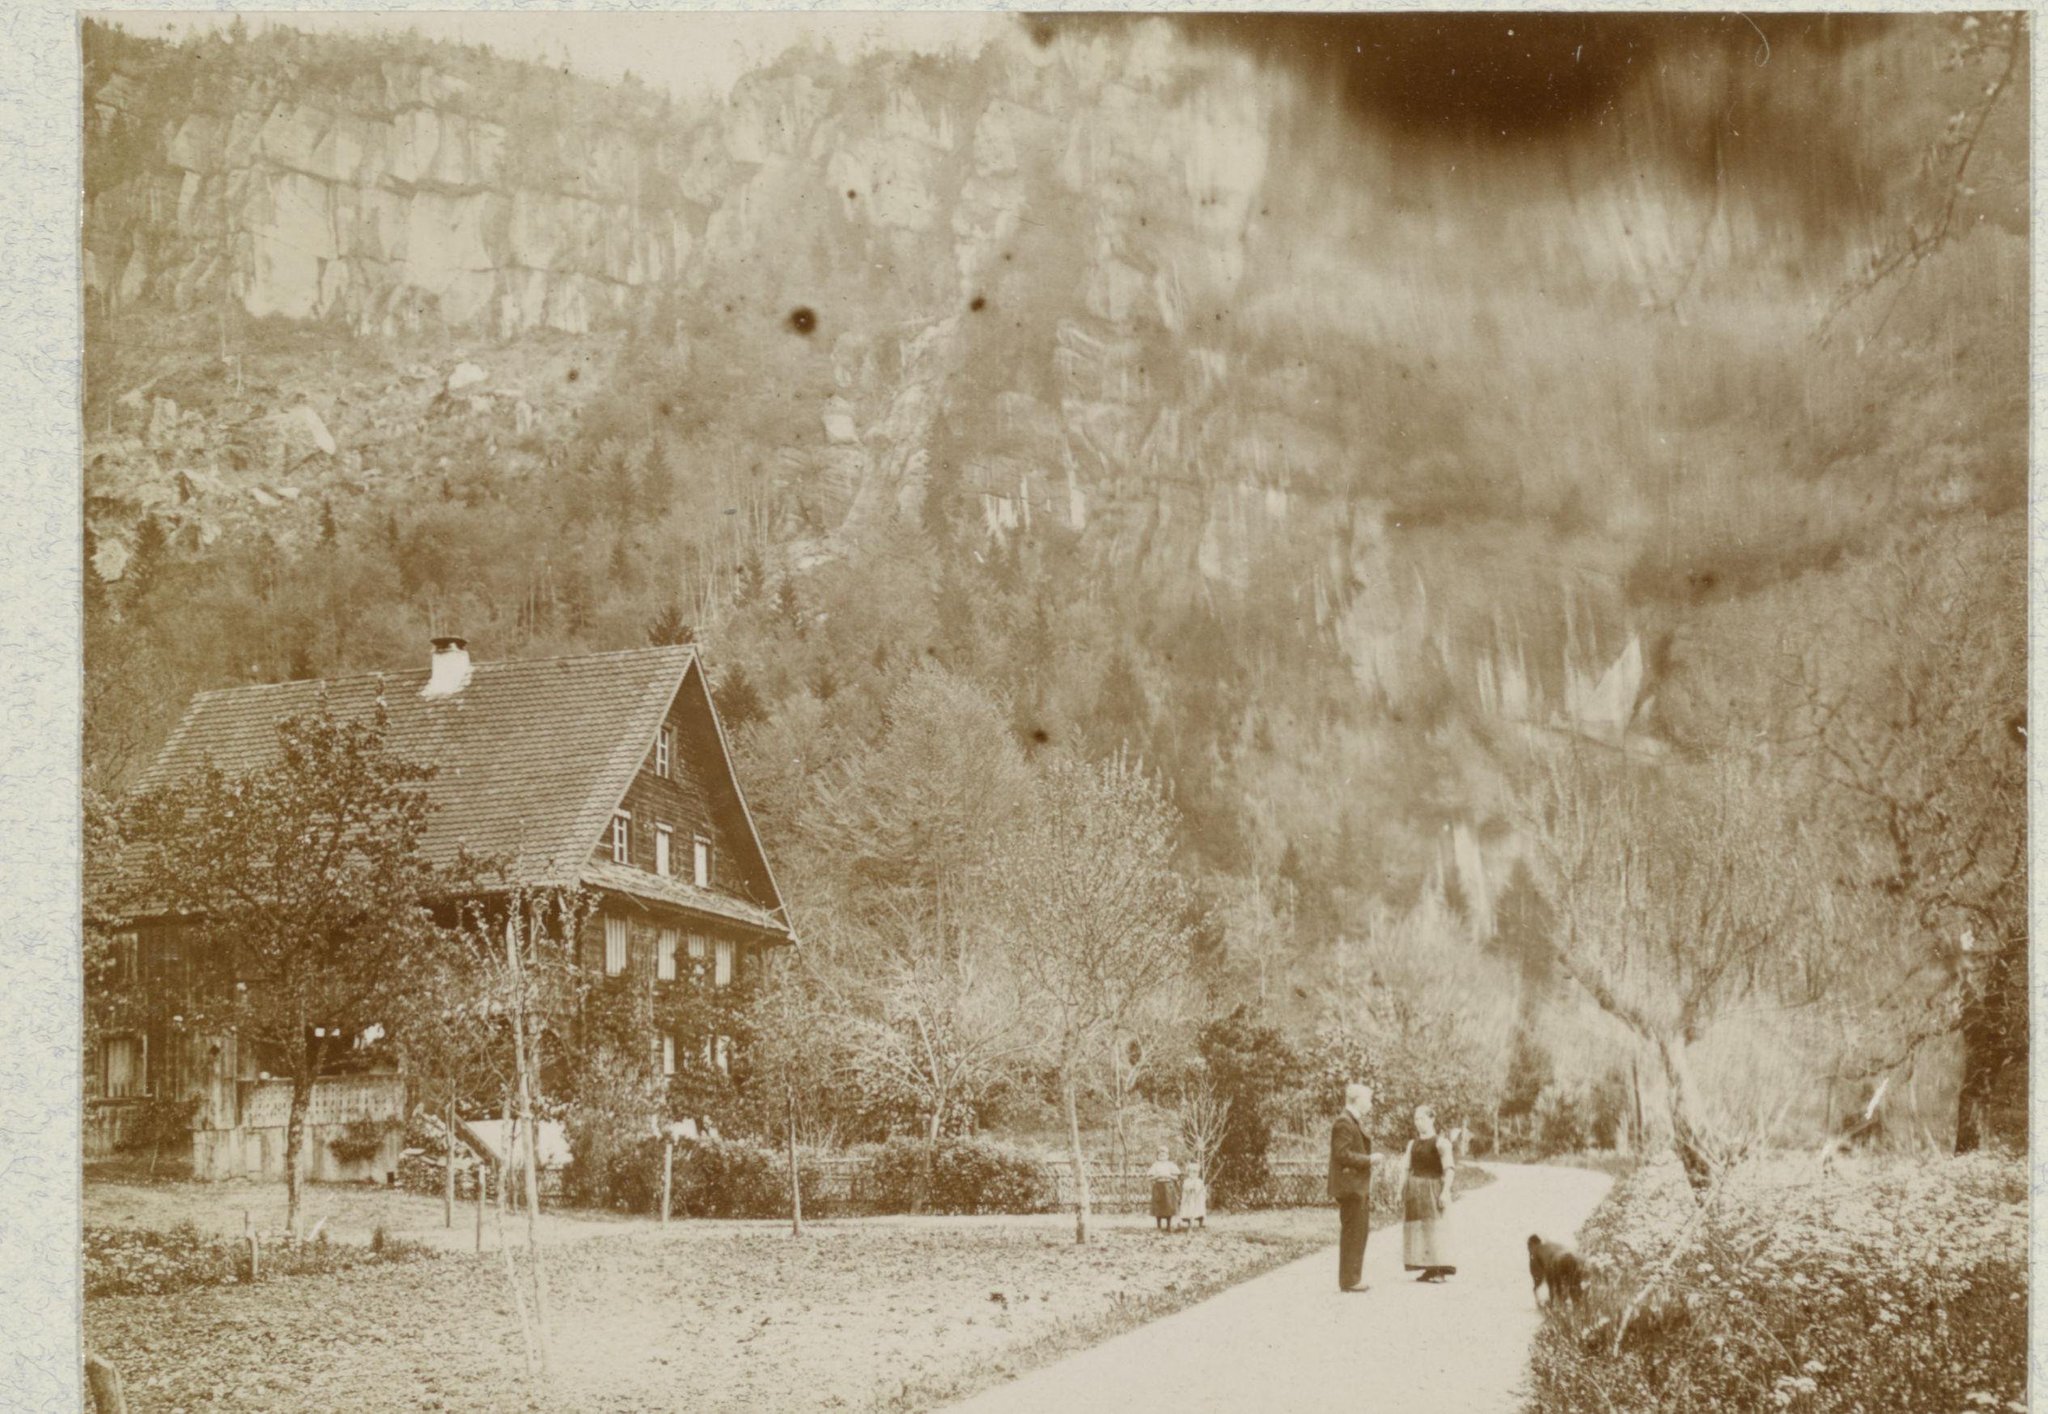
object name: photograph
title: Vakantie in Zwitserland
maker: andries augustus boom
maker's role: amateurfotograaf, handelaar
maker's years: 1878-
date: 1805-1899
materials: photographic support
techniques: photography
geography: switzerland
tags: andries augustus boom, switzerland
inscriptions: date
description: Vakantie in Vitznau, Zwitserland. Onderdeel van het fotoalbum van de familie Boom-Gonggrijp in Suriname en Curaçao.